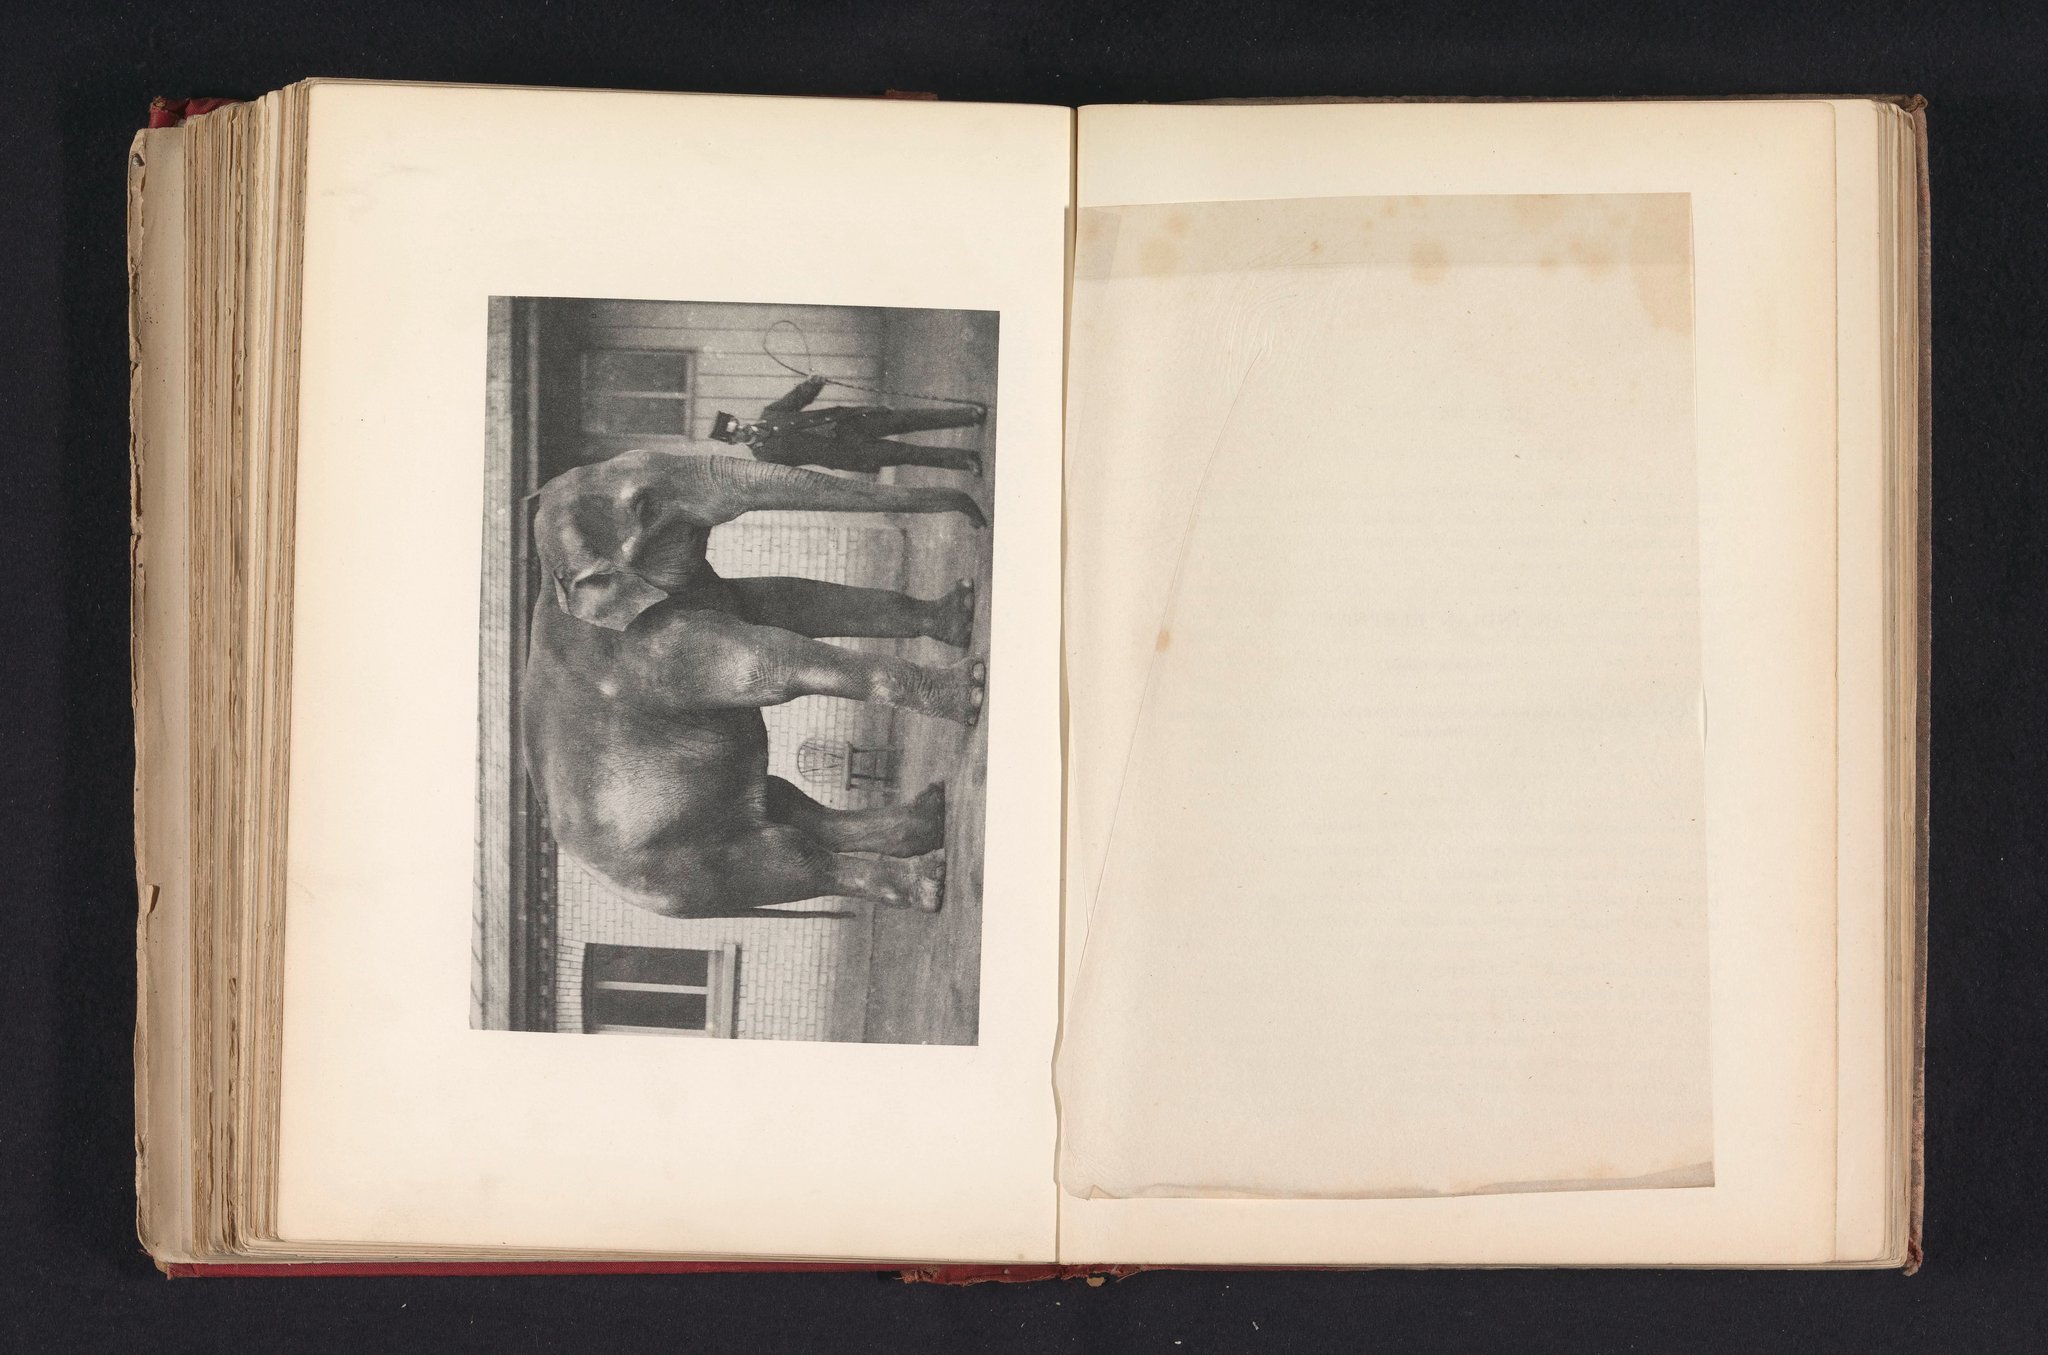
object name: page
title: An Indian elephant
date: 1876-1886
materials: paper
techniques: photograph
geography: paris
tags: zoological garden, zoo, seen as place where non-domestic animals are kept, trunked animals: elephant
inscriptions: inscription: ‘"Jung Perchad" was presented to the Prince of Wales when in India by Sir Salar Jung Bahawdur.’